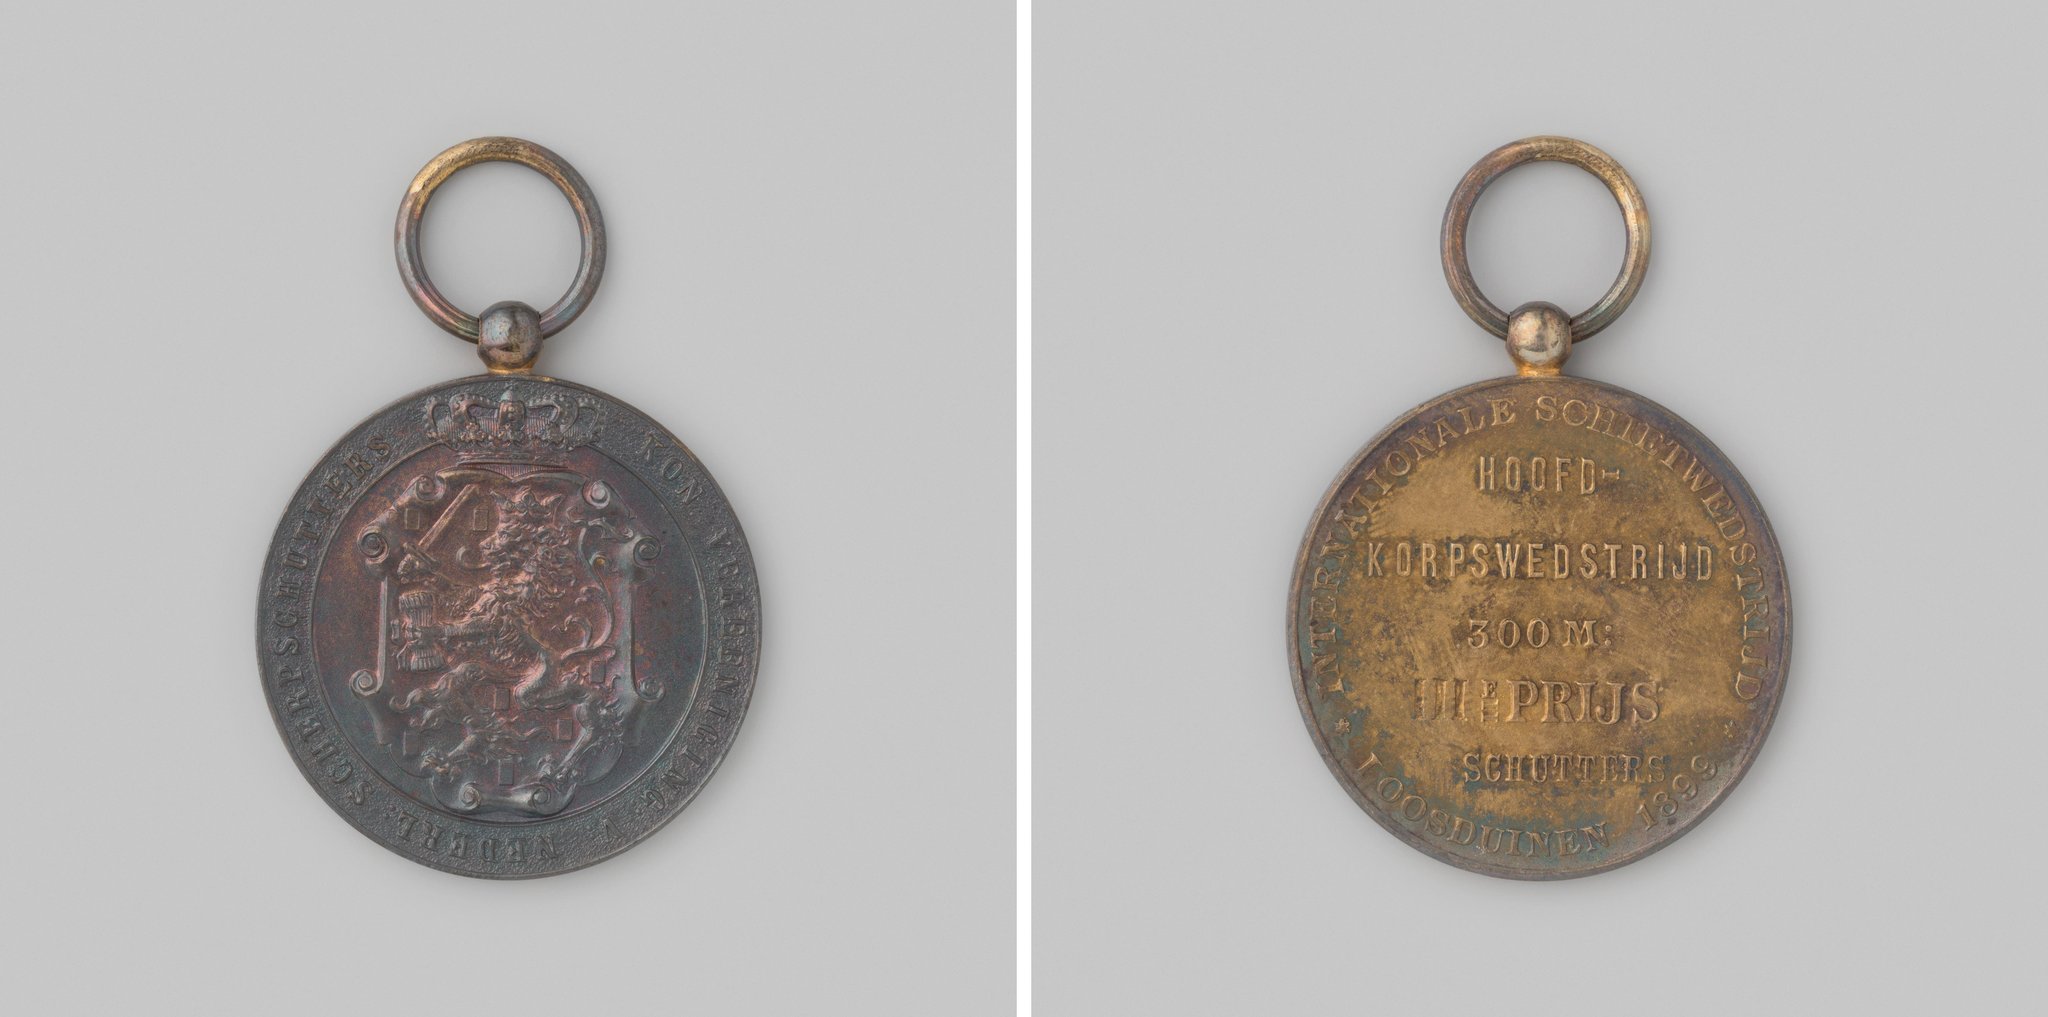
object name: medal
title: Prijspenning van de Vereeniging van Nederlandsche Scherpschutters, 1899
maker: Anonymous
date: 1899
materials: silver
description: Verguld zilveren penning met oog en ring van de Vereeniging van Nederlandsche Scherpschutters, behaald door het regiment Schutterij te Amsterdam, 1899. Voorzijde: het Nederlandse wapen in renaissancestijl. Omschrift: VEREENIGING VAN NEDERLANDSCHE SCHERPSCHUTTERS. Keerzijde: lauwerkrans